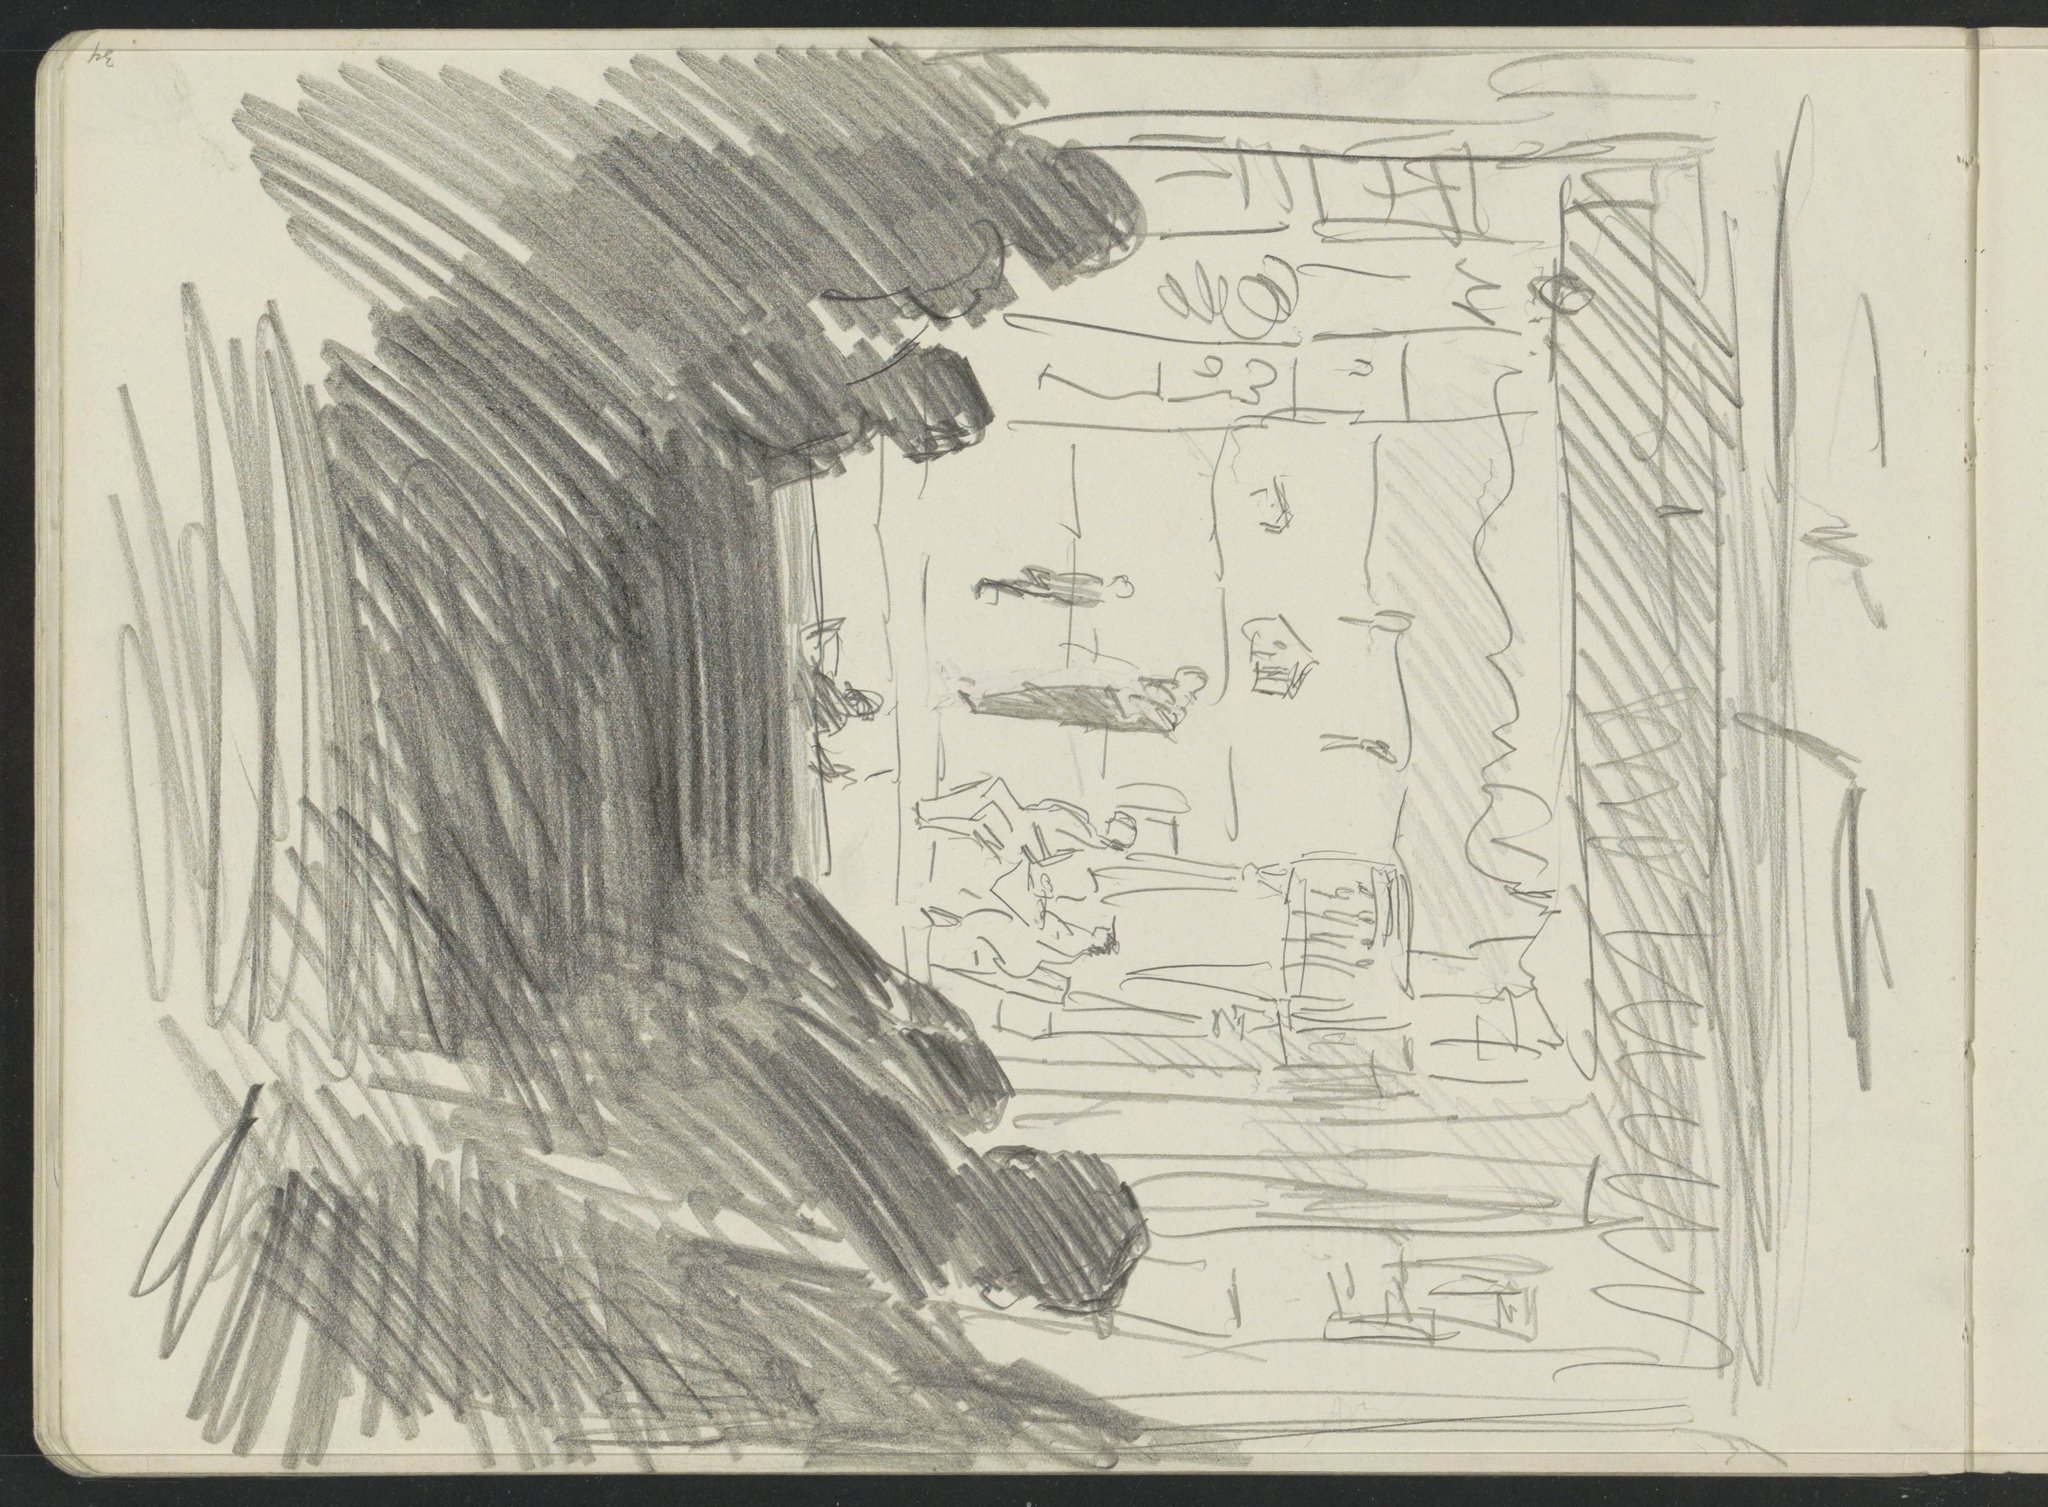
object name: sketchbook leaf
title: Theatervoorstelling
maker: isaac israels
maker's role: draughtsman, painter, print maker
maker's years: 1865-1934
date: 1915-1934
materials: paper, pencil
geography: the hague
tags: group of actors, troupe; actors on the stage, the audience ~ art performance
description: Vooraan toeschouwers, op de rug gezien. Op de achtergrond de orkestbak en acteurs op het toneel. Blad 29 verso uit schetsboek XVII met 31 bladen.